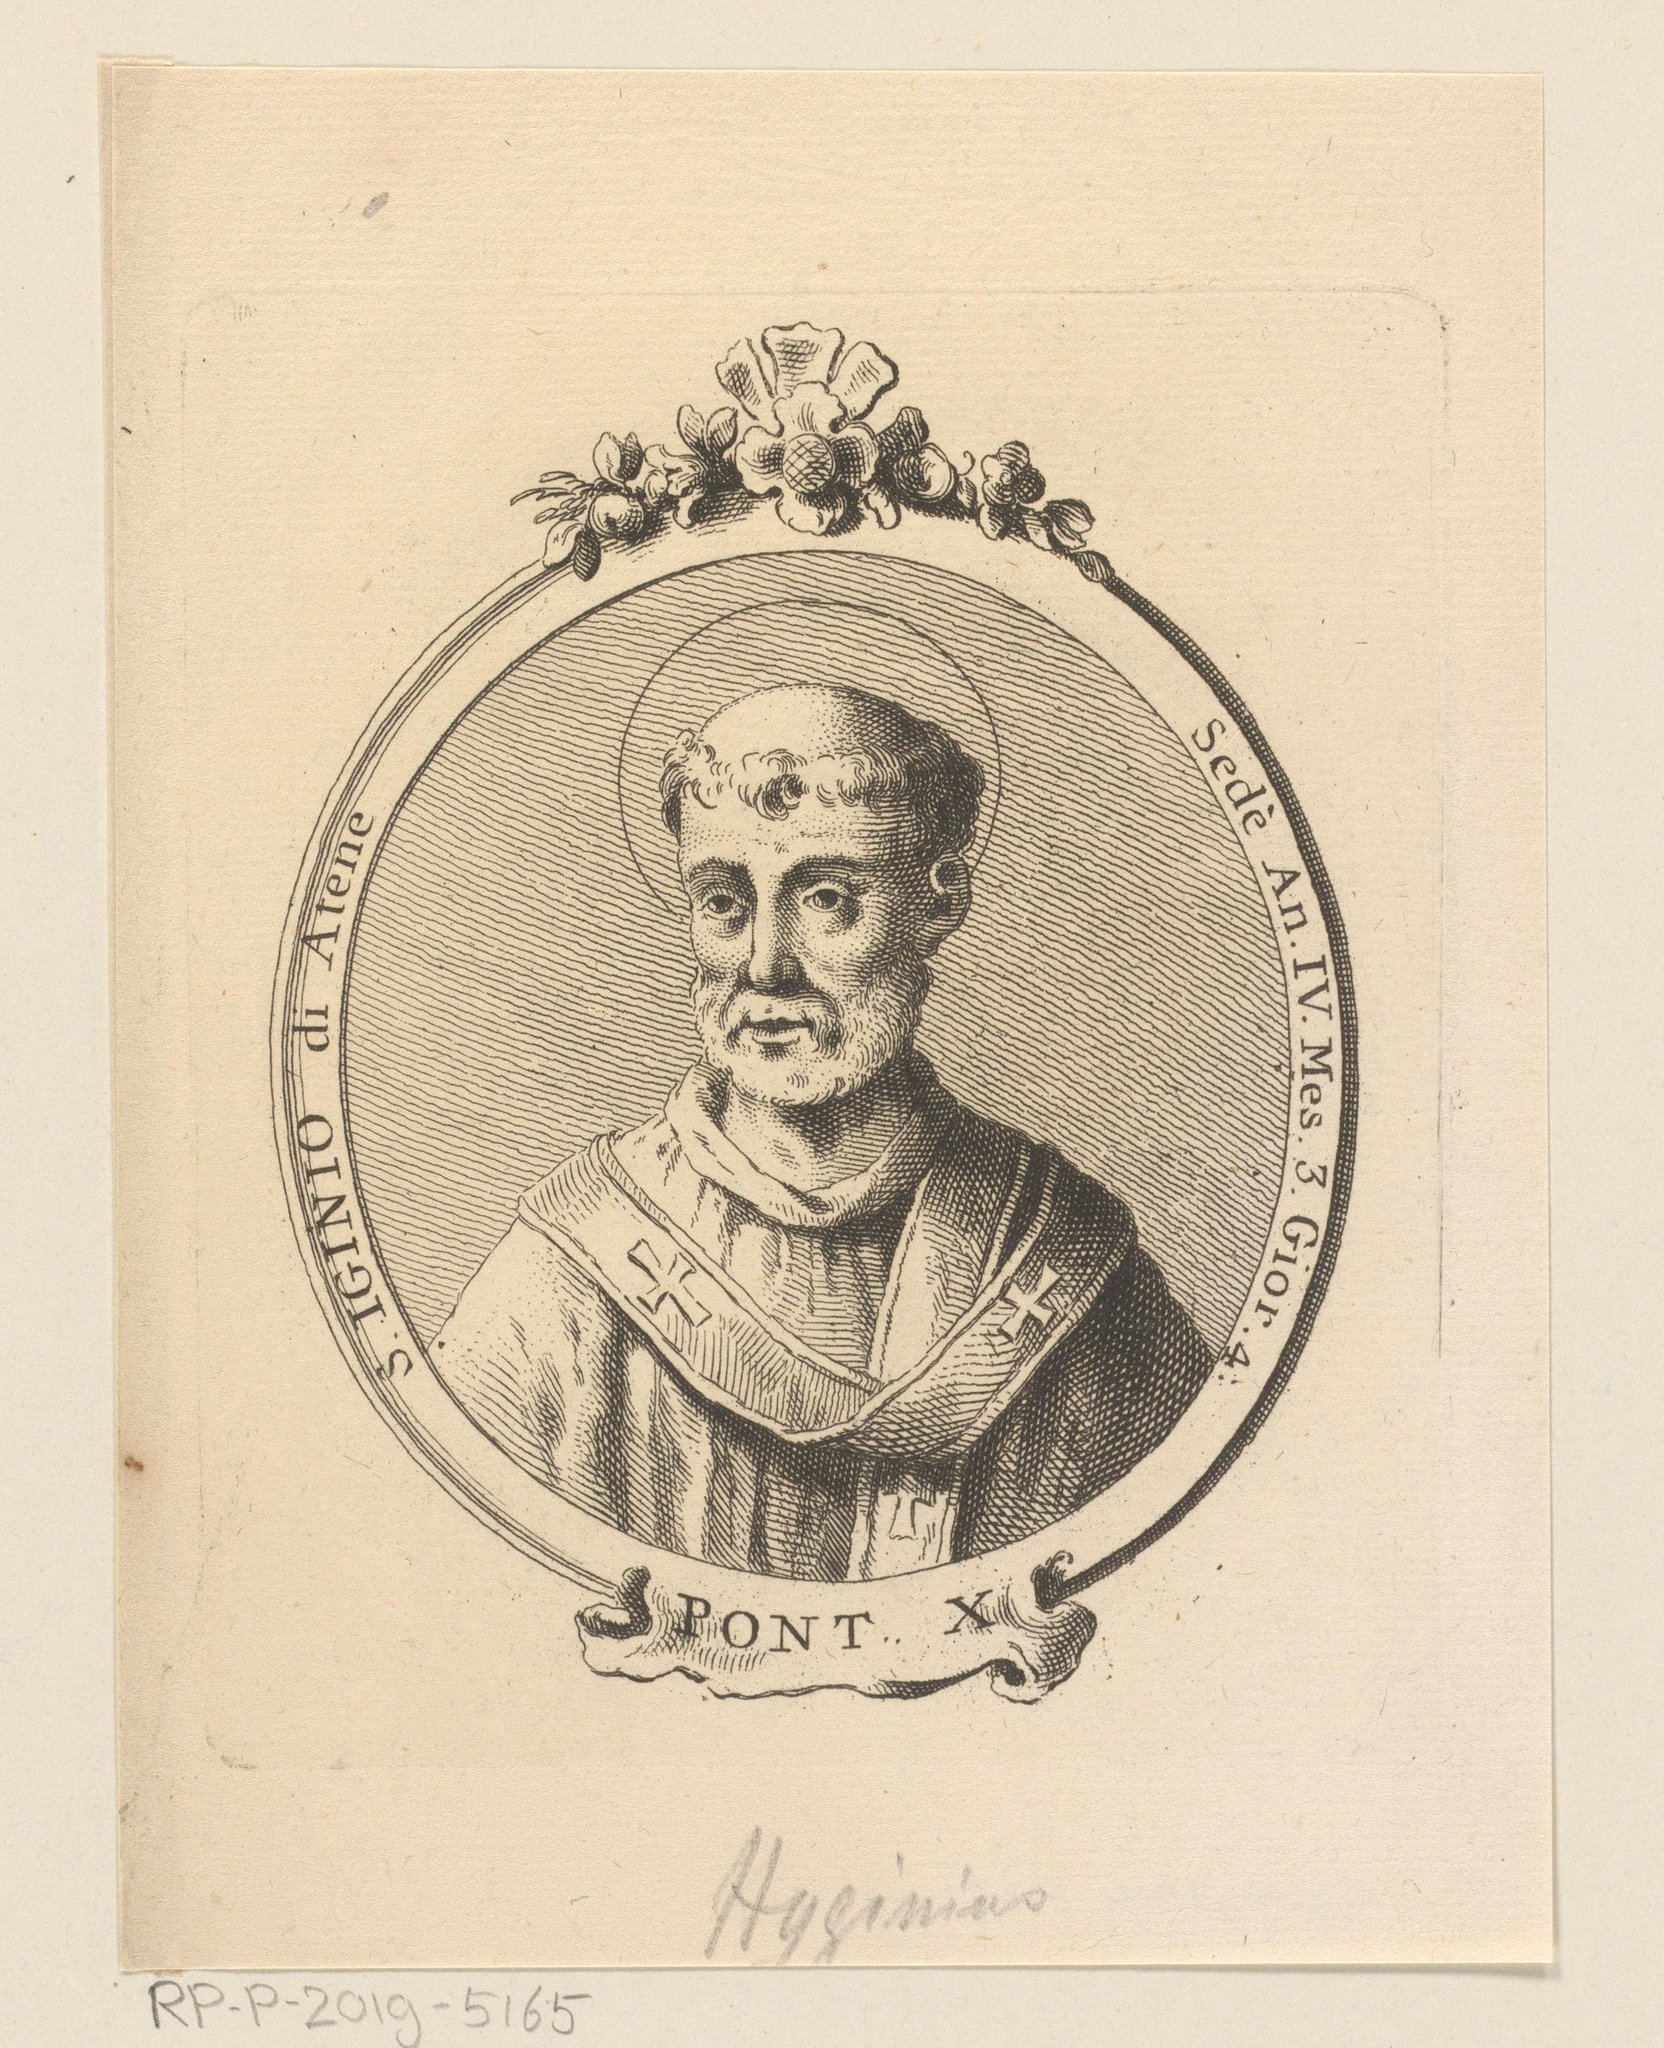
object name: book illustration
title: S. Iginio di Atene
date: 1775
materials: paper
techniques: engraving, etching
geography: venice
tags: rome, historical persons, pope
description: Prent uit: Effigies Romanorum pontificum a S. Petro ad Pium VI. feliciter regnantem (...). 2 dln. Venetië en Bassano del Grappa: Giuseppe Remondini, 1775.